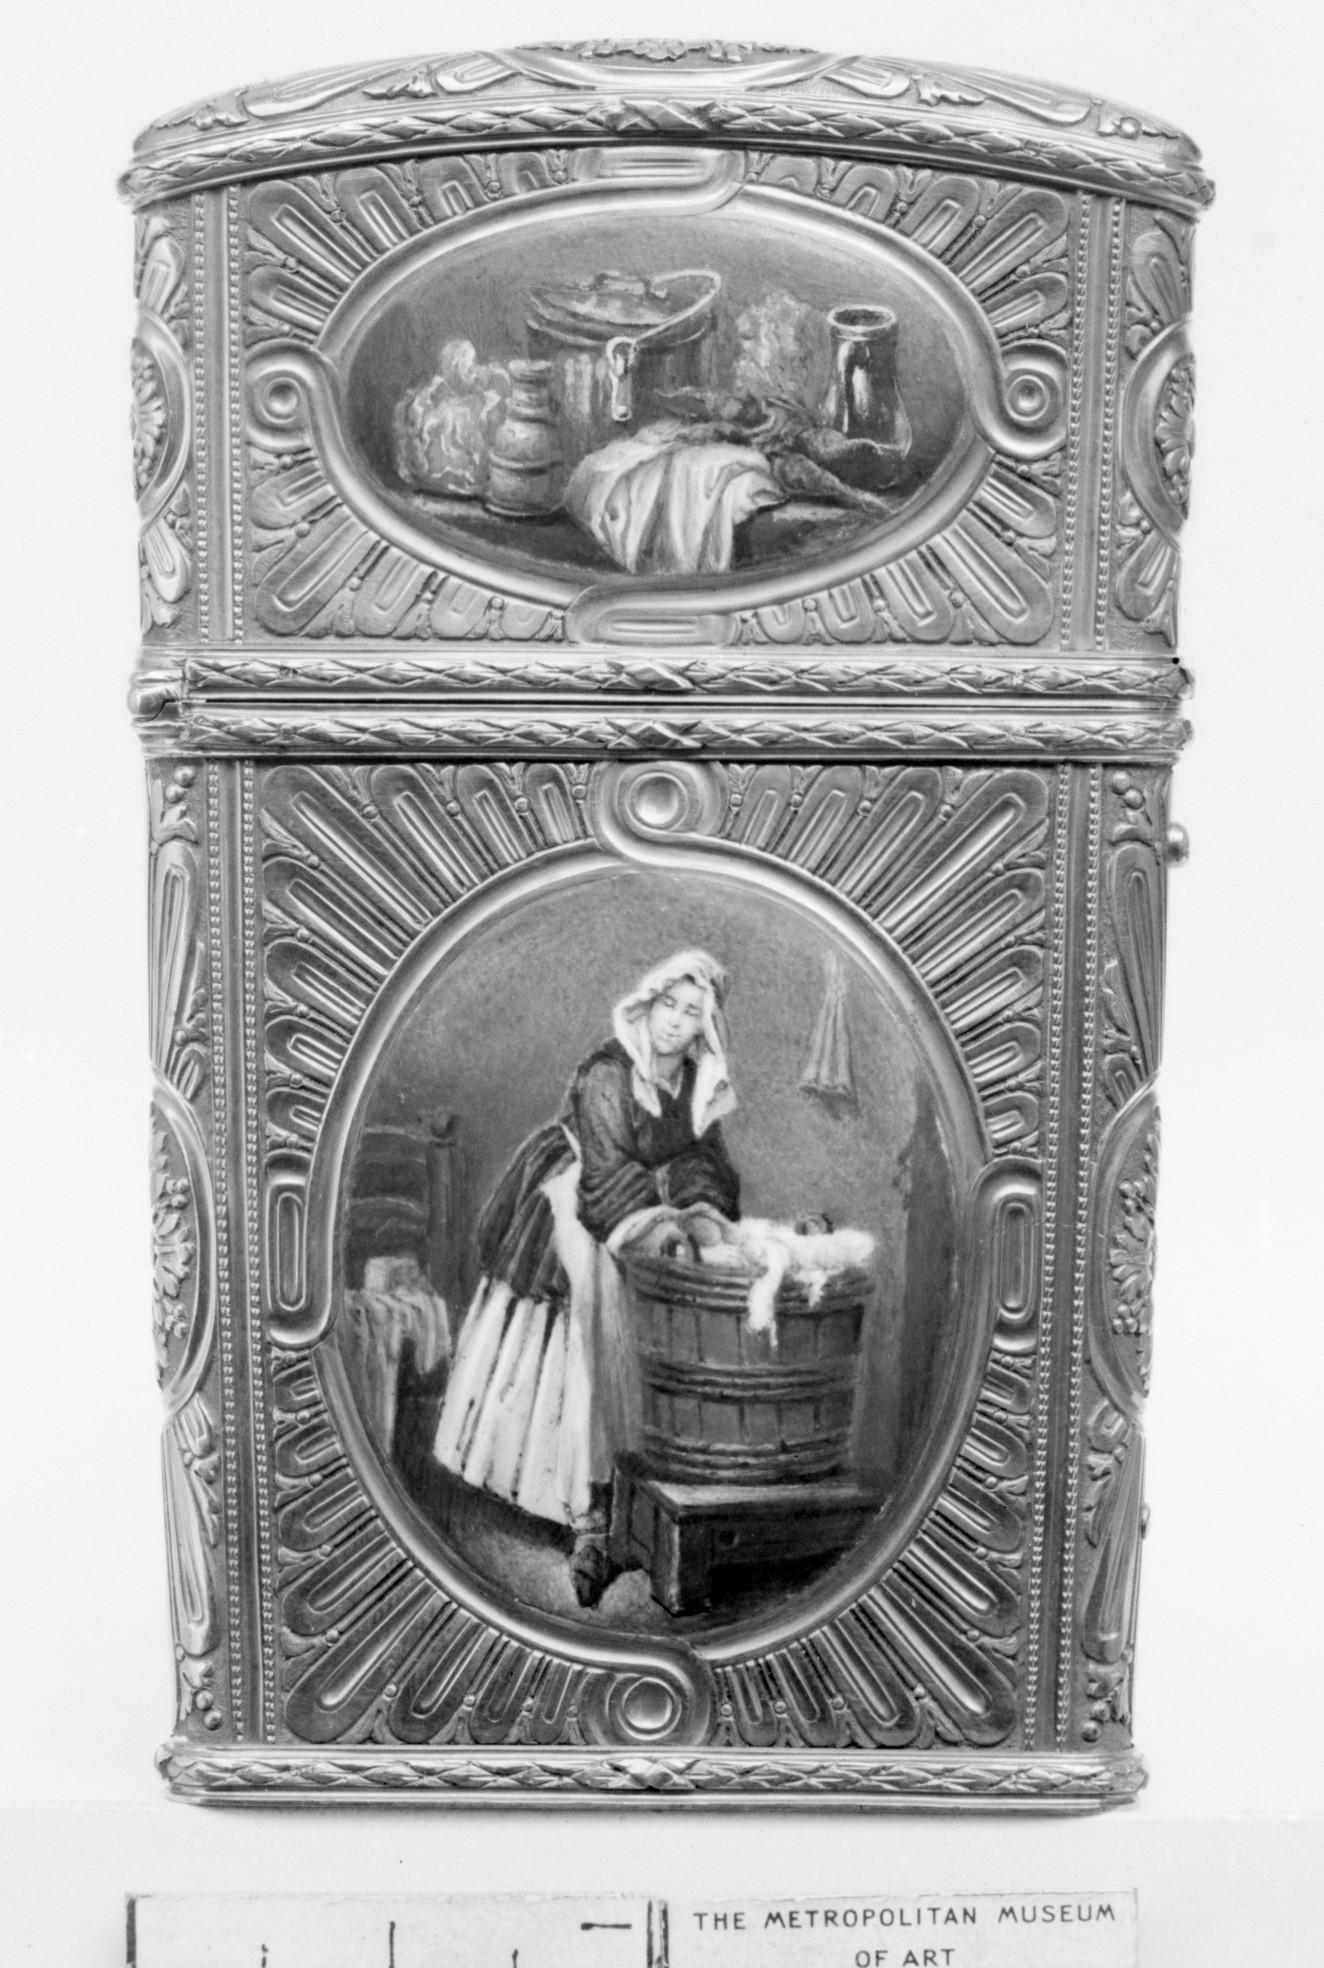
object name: souvenir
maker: jean-nicolas defer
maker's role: maker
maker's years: 1783-1793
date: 1784-1785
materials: enamel, gold, ivory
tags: women